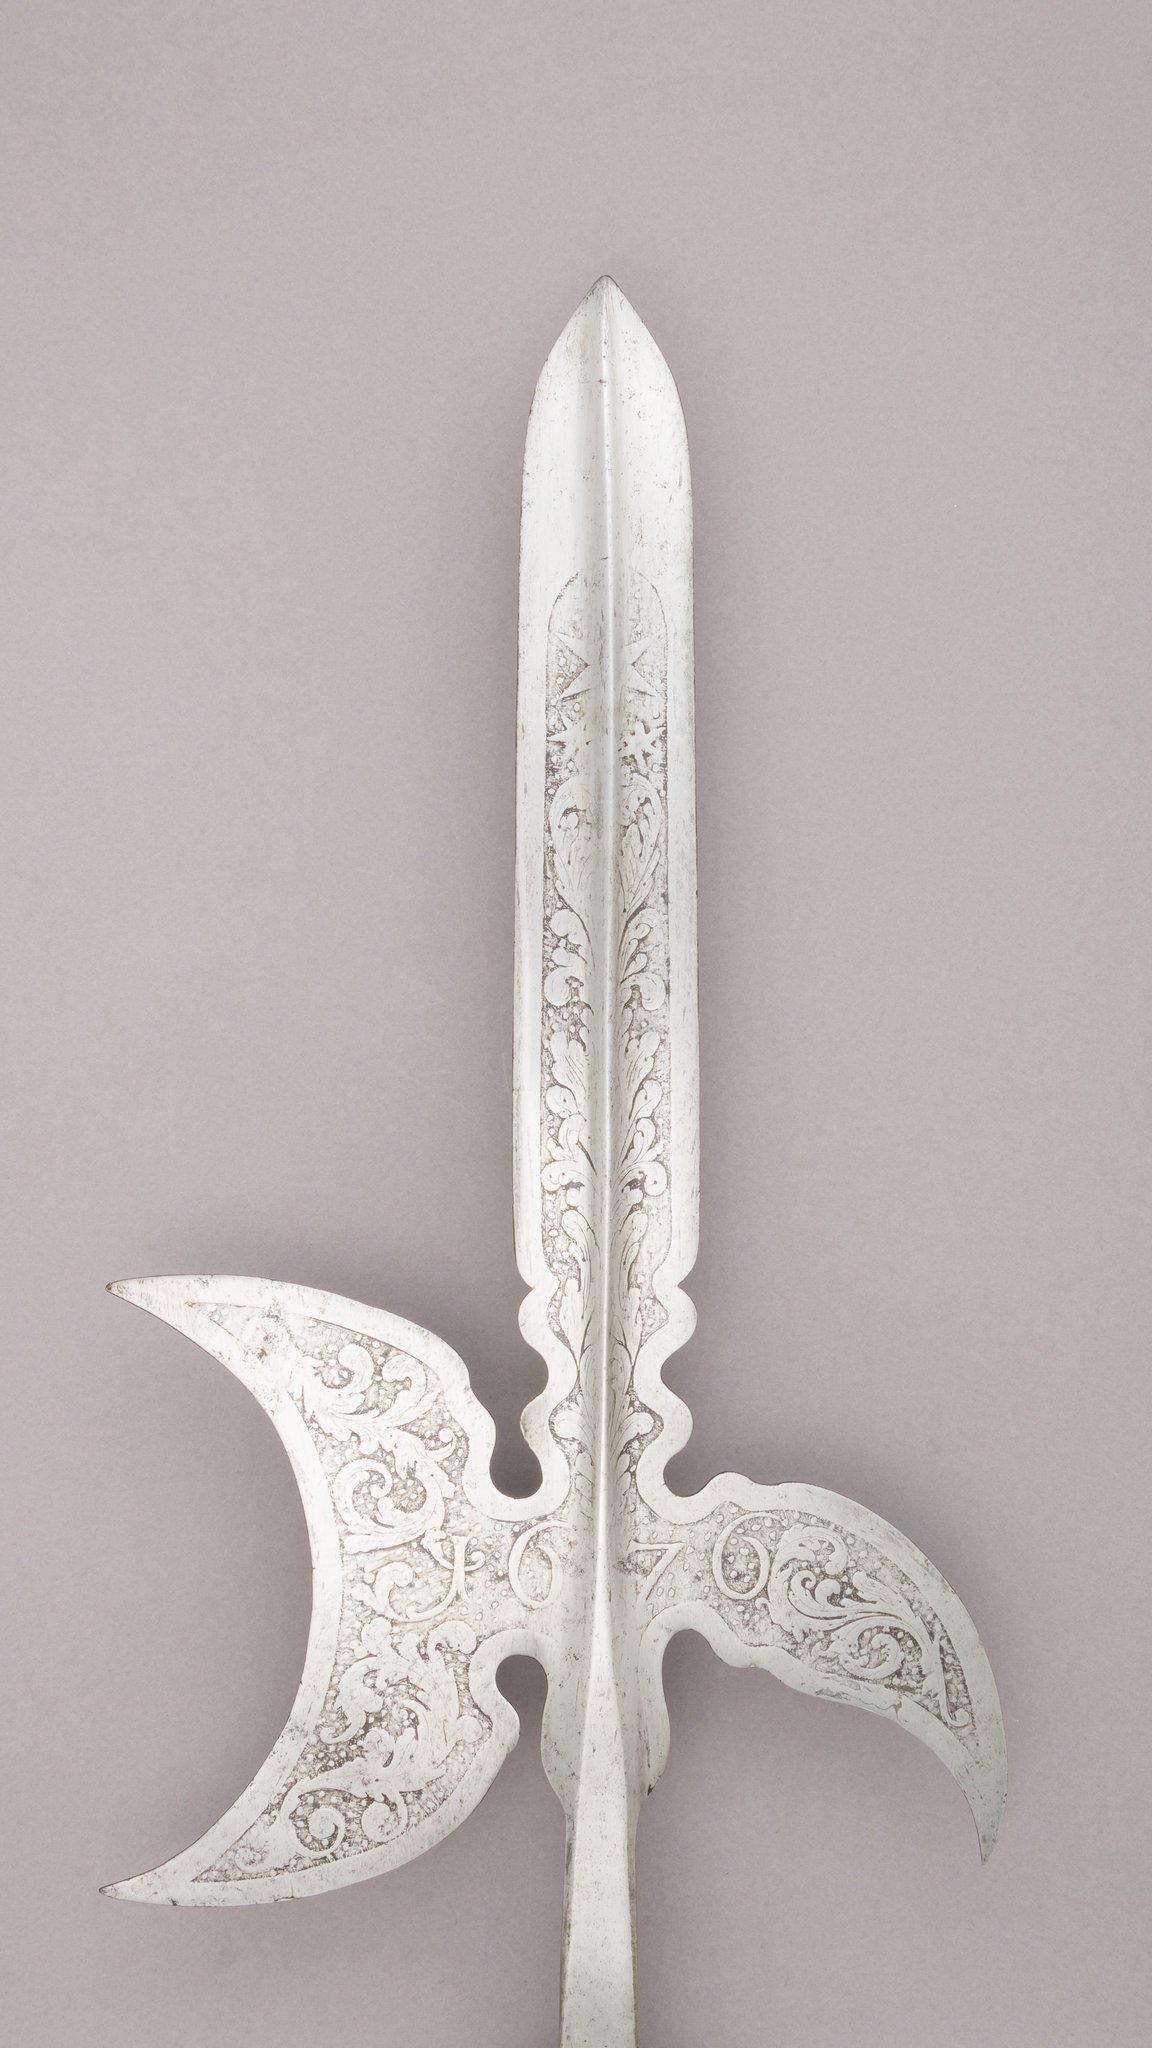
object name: halberd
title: Halberd of Frederick of Hesse, Prince-Bishop of Breslau (reigned 1671–82)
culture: german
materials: steel, textile, wood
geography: germany